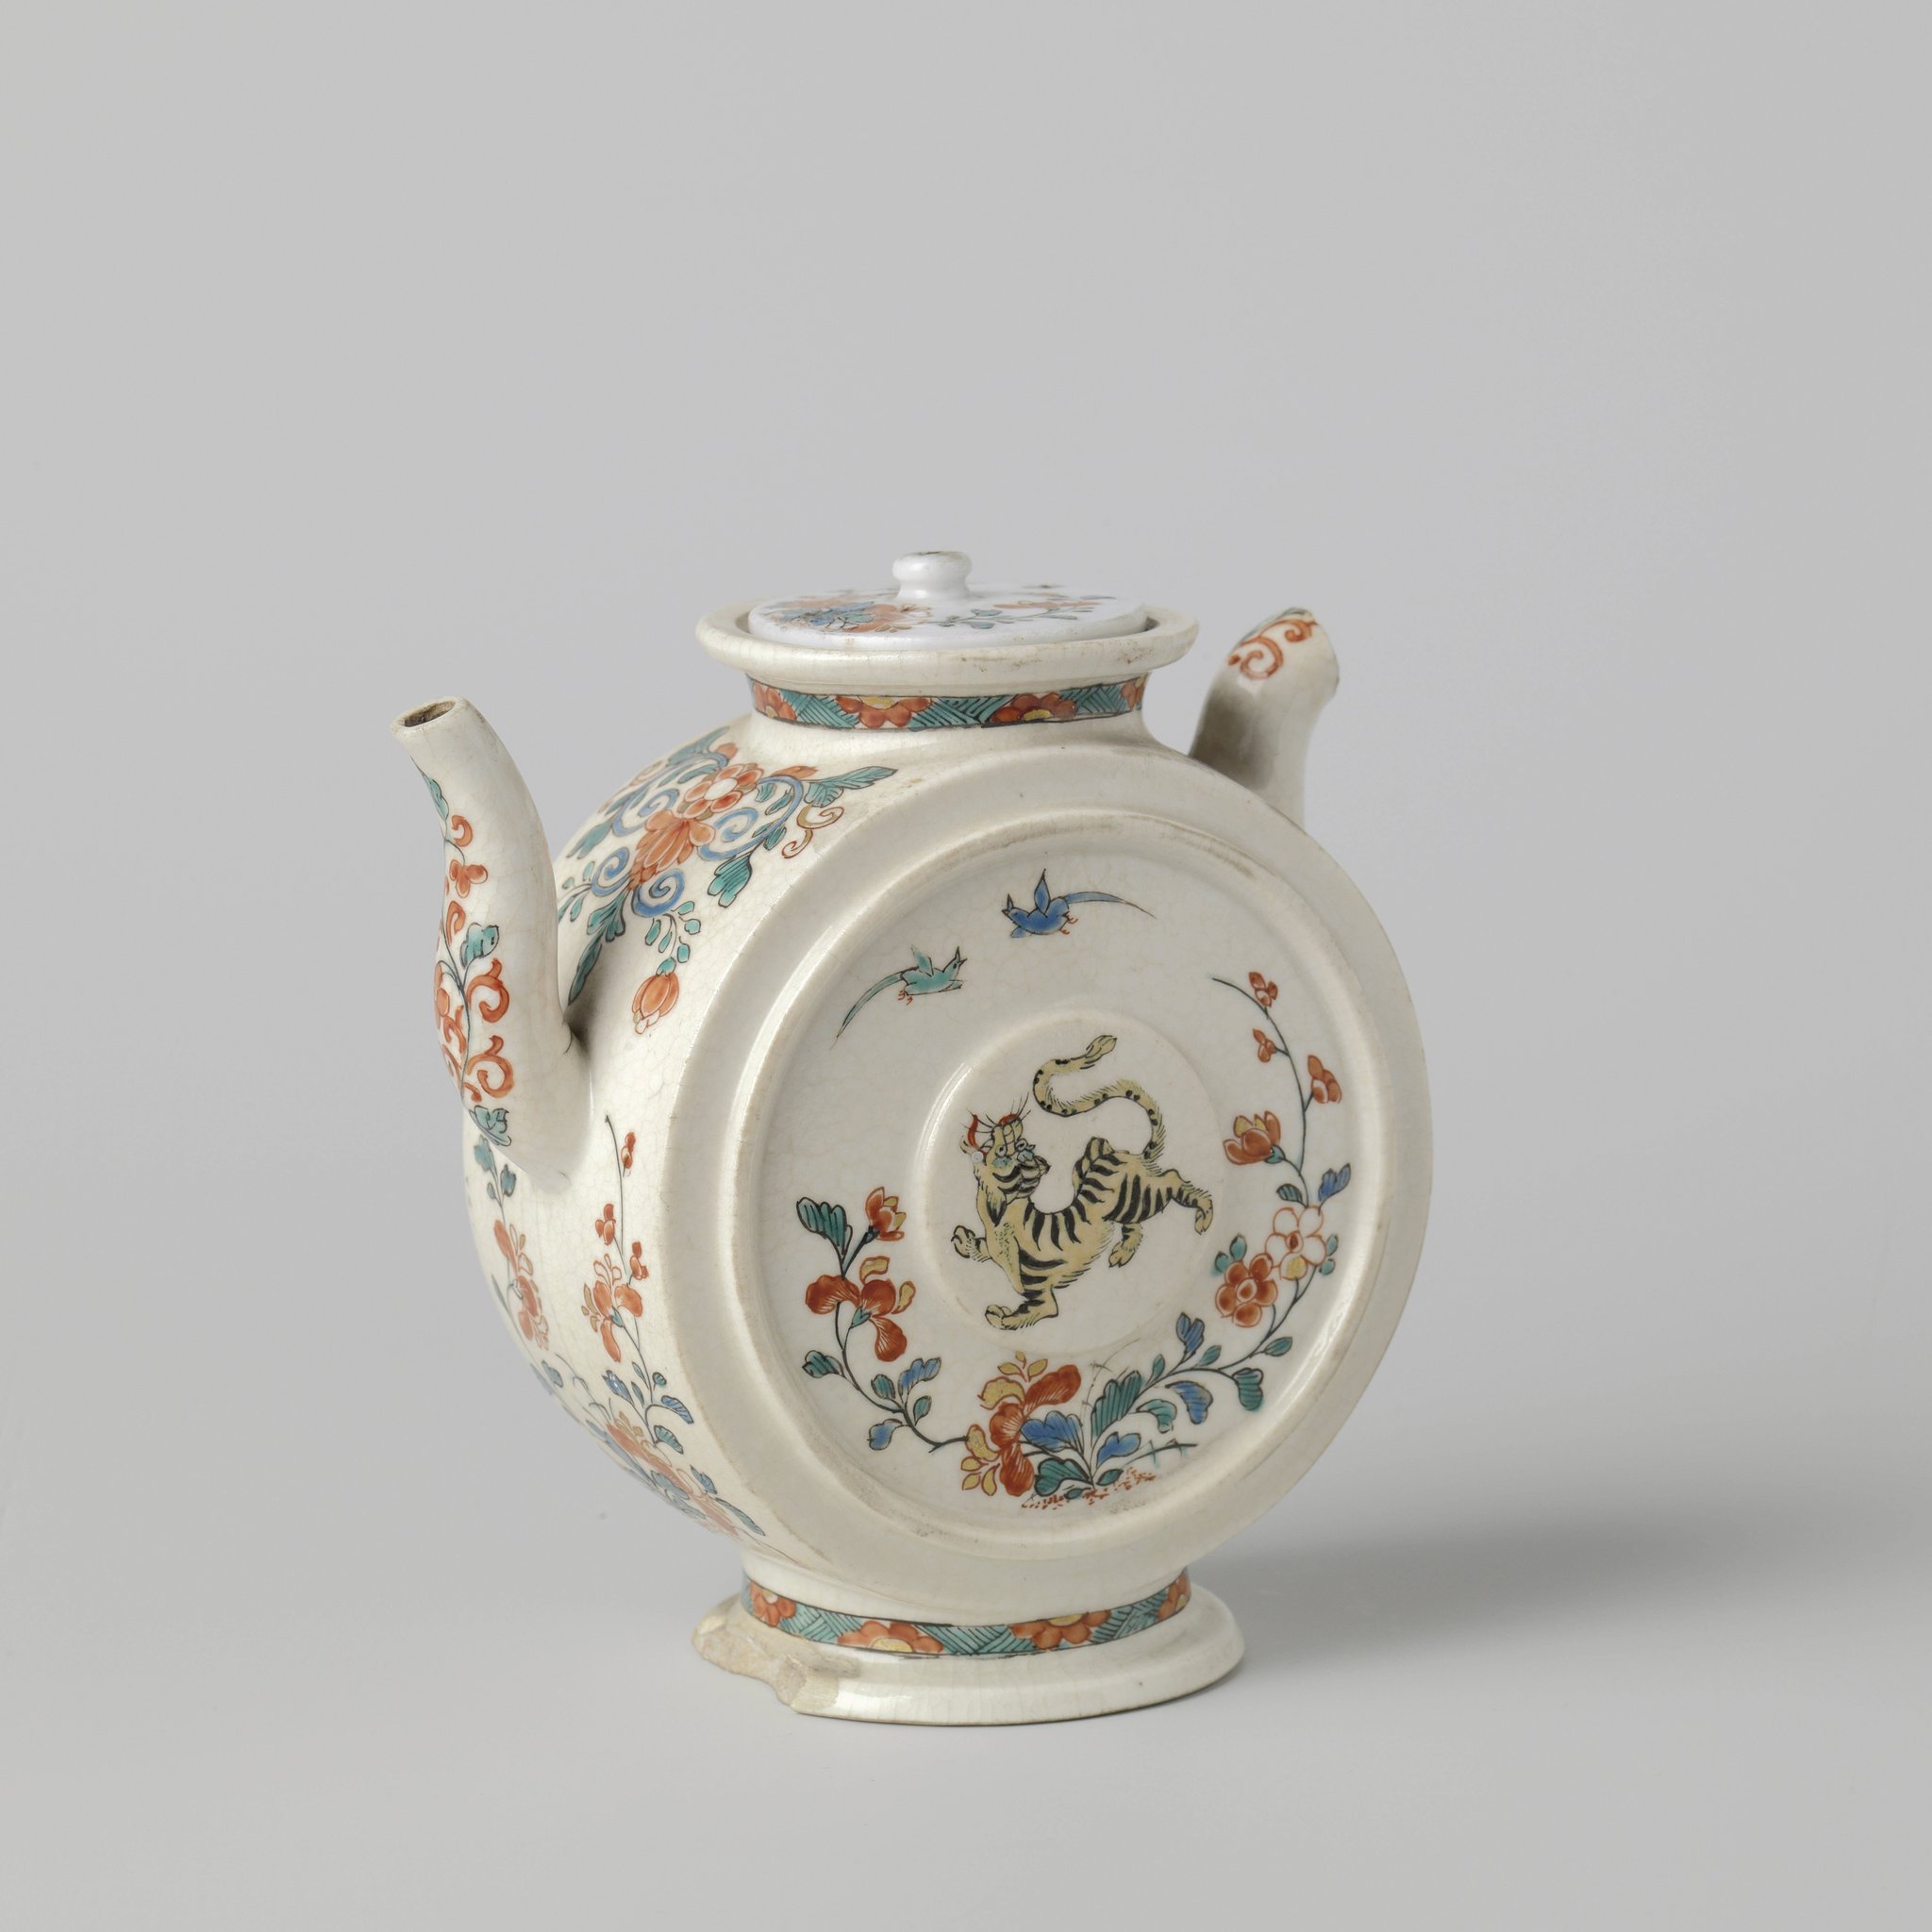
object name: teapot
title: Teapot with a tiger, birds and floral scrolls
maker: Anonymous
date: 1700-1799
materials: glaze, gold, paint, porcelain, soft paste porcelain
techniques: firing, forming, gilding, turning, vitrification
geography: japan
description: Theepot van soft-paste porselein (pâte tendre) op voet en een S-vormige tuit, beschilderd op het glazuur in blauw, rood, groen, geel, zwart en goud. De buik is in de vorm van een op de zijkant staande cilinder, met op de platte wand een verhoogd medaillon en een verhoogde cirkel. Op de wand een tijger, twee vogels en een bloeiende plant. De ronde wand, de tuit en het oor met bloemranken. Op de nek en de voet een band met arceerwerk onderbroken door halve bloemen. Het oor is grotendeels afgebroken. Deksel van porselein met bloemranken is niet bijpassend. Kakiemon-stijl.